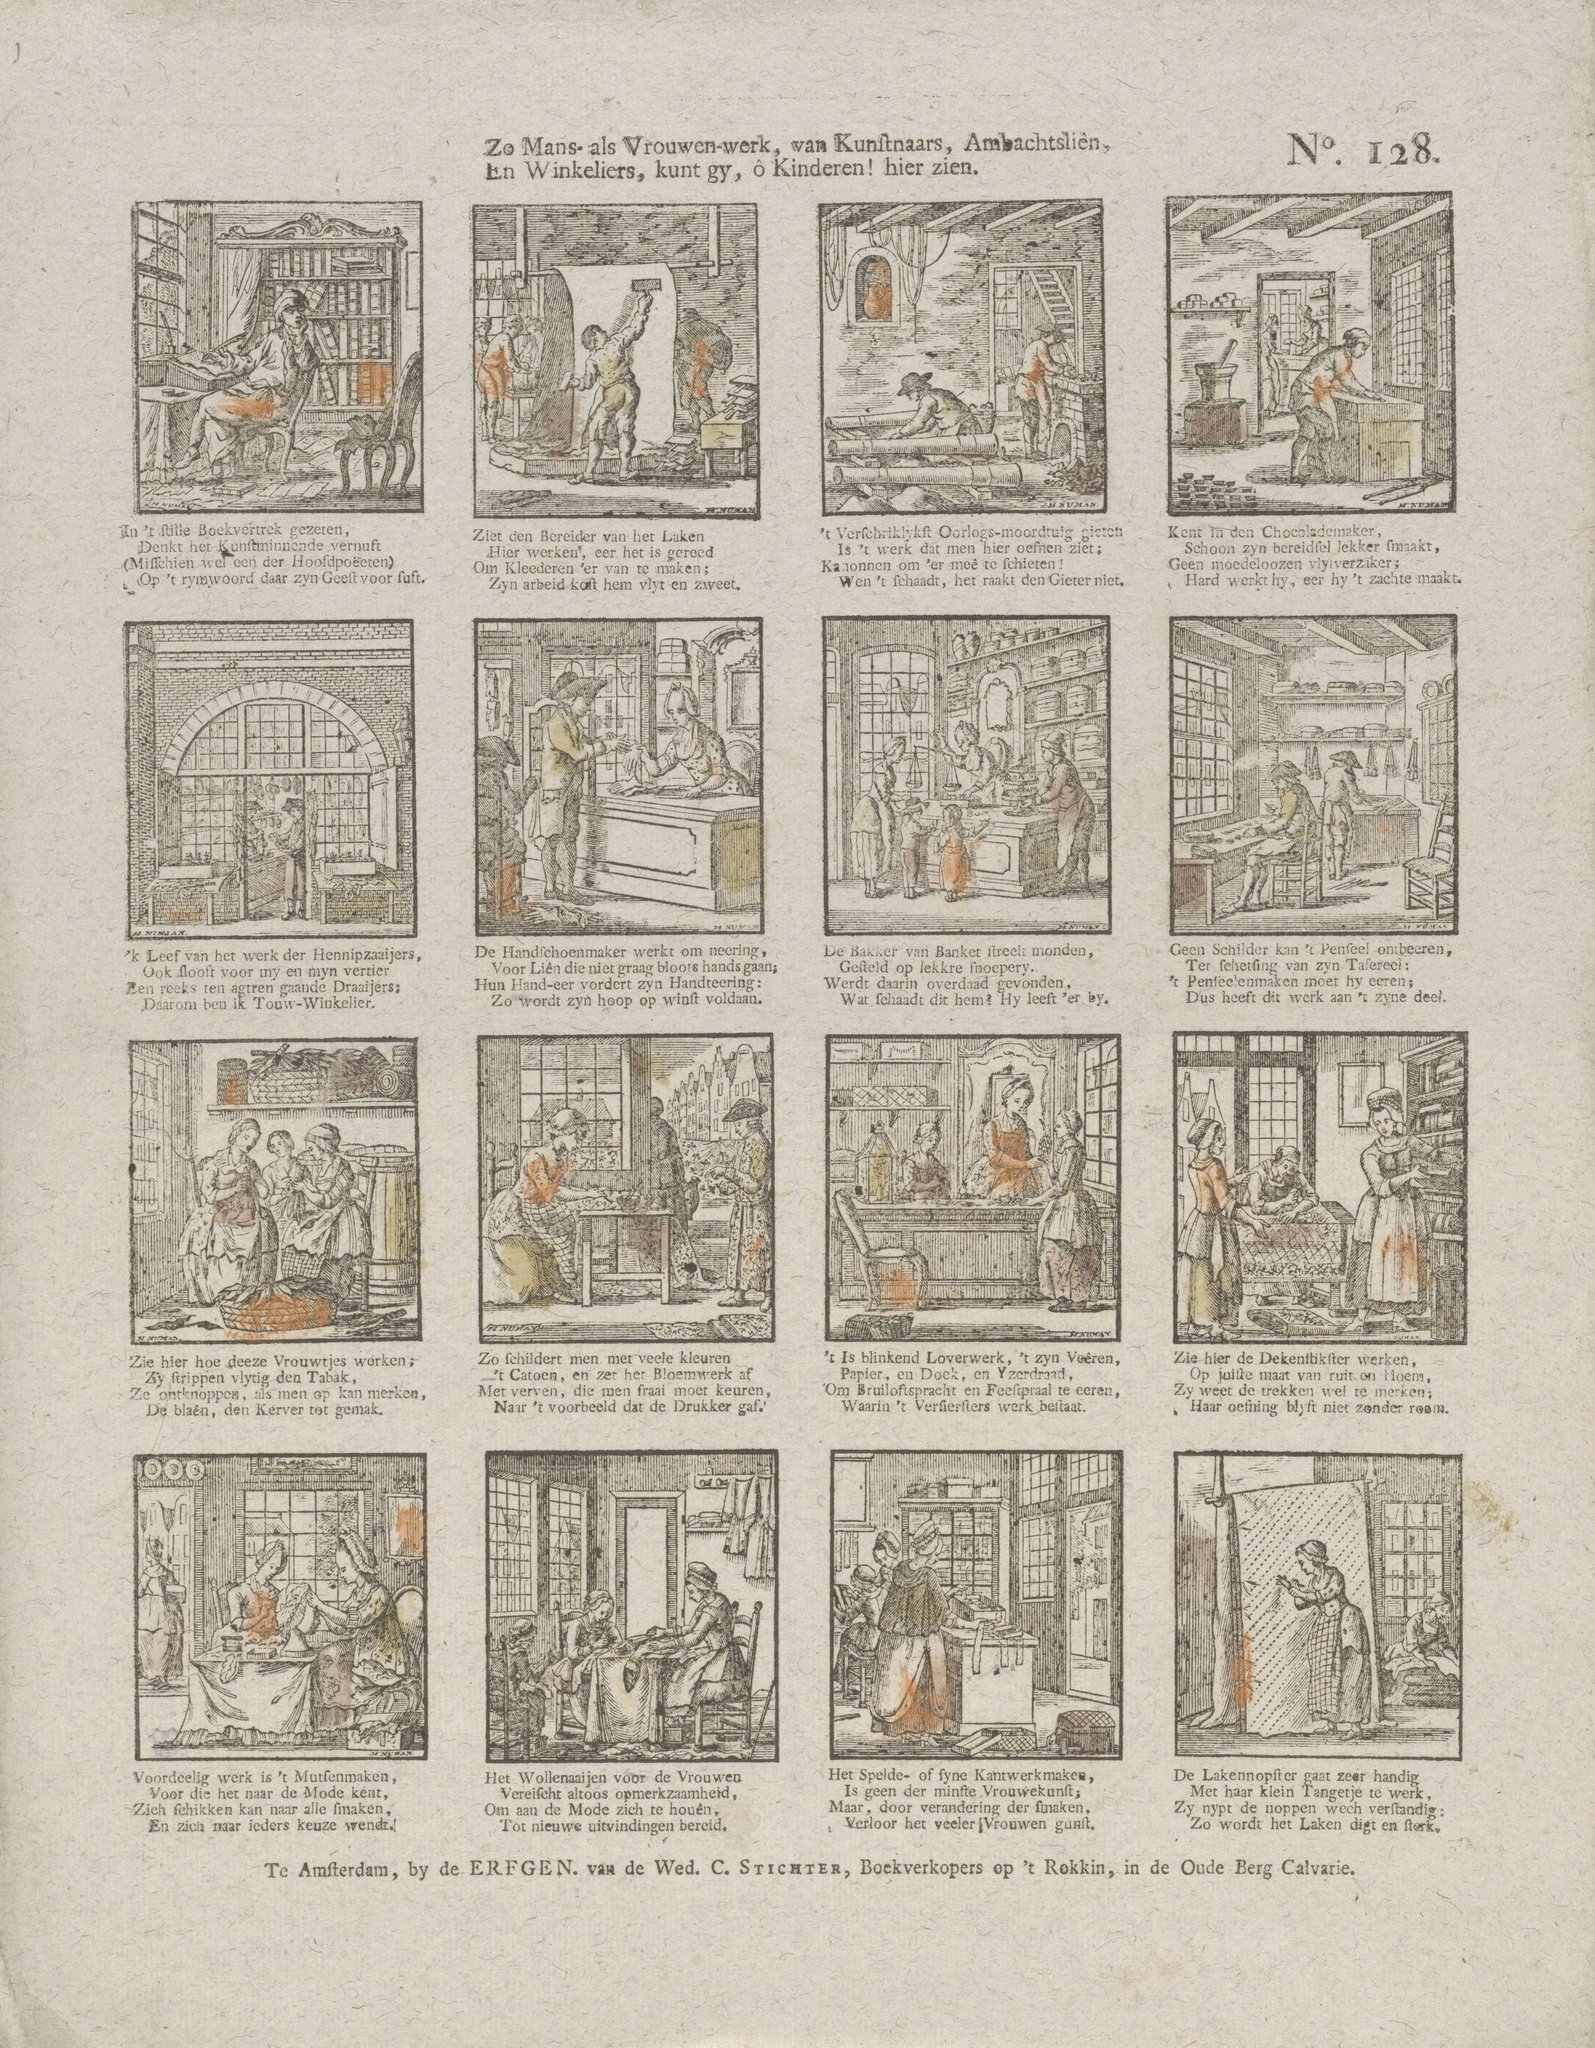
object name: popular print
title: Zo mans- als vrouwen-werk, van kunstenaars, ambachtsliên, / En winkeliers, kunt gy, ô kinderen! hier zien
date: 1770-1788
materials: paper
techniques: colour, letterpress printing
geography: amsterdam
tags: handicrafts and industries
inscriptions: collector's mark: Lugt 2760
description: Blad met 16 voorstellingen van ambachten voor mannen en vrouwen. Onder elke afbeelding een vierregelig vers. Genummerd: No. 128.